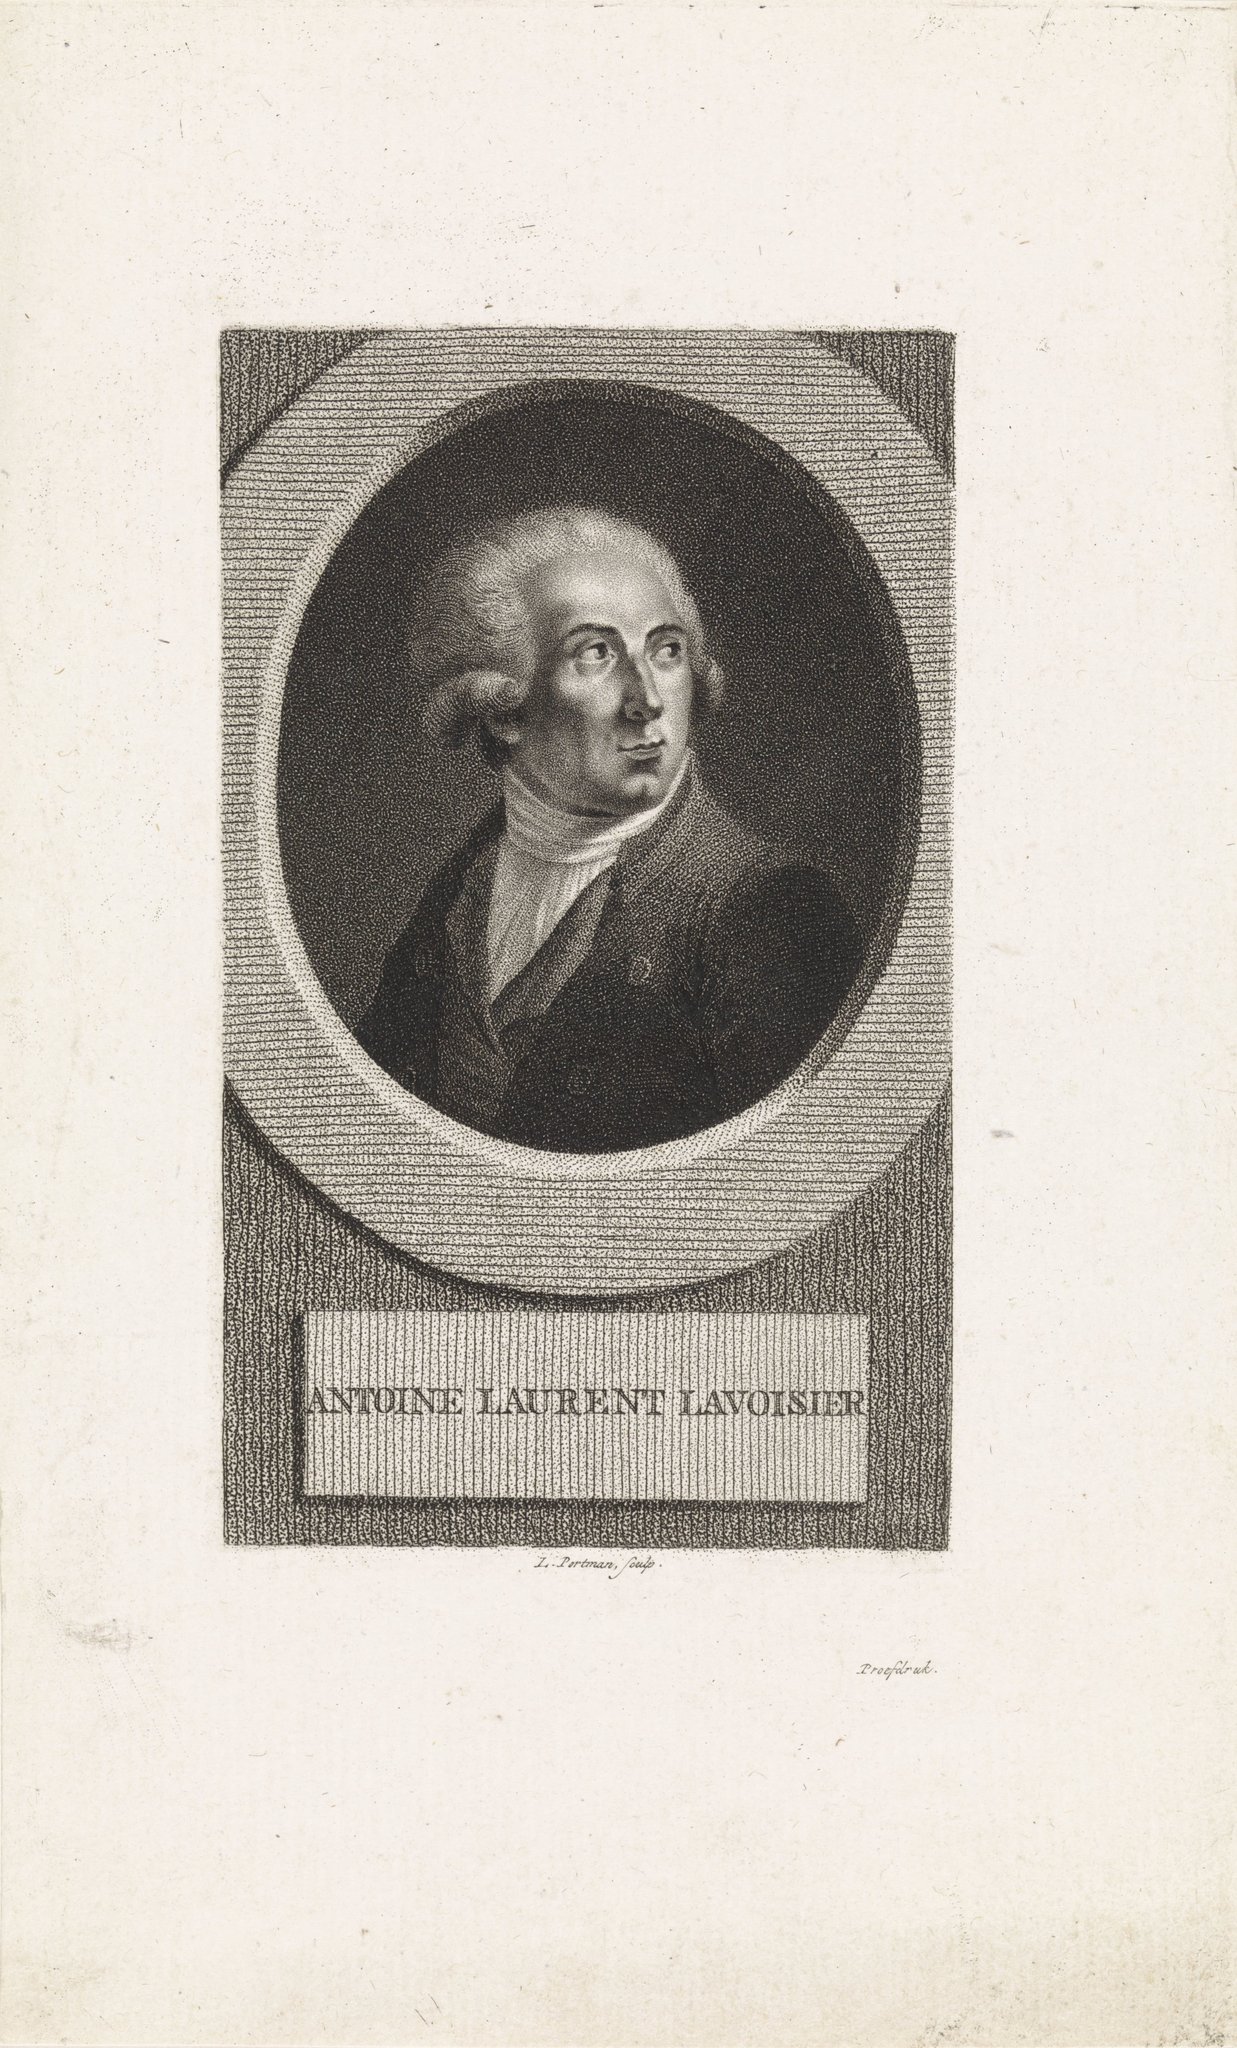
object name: print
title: Portret van de Franse scheikundige Antoine Laurent Lavoisier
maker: ludwig gottlieb portman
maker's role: print maker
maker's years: 1772-1828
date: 1804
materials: paper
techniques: stippled etching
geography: amsterdam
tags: antoine laurent lavoisier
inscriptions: collector's mark: Lugt 2228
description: Prent ook gebruikt als illustratie in: Tafereelen van de staatsomwenteling in Frankrijk, deel 19, p. 152. Amsterdam: Johannes Allart, 1804.